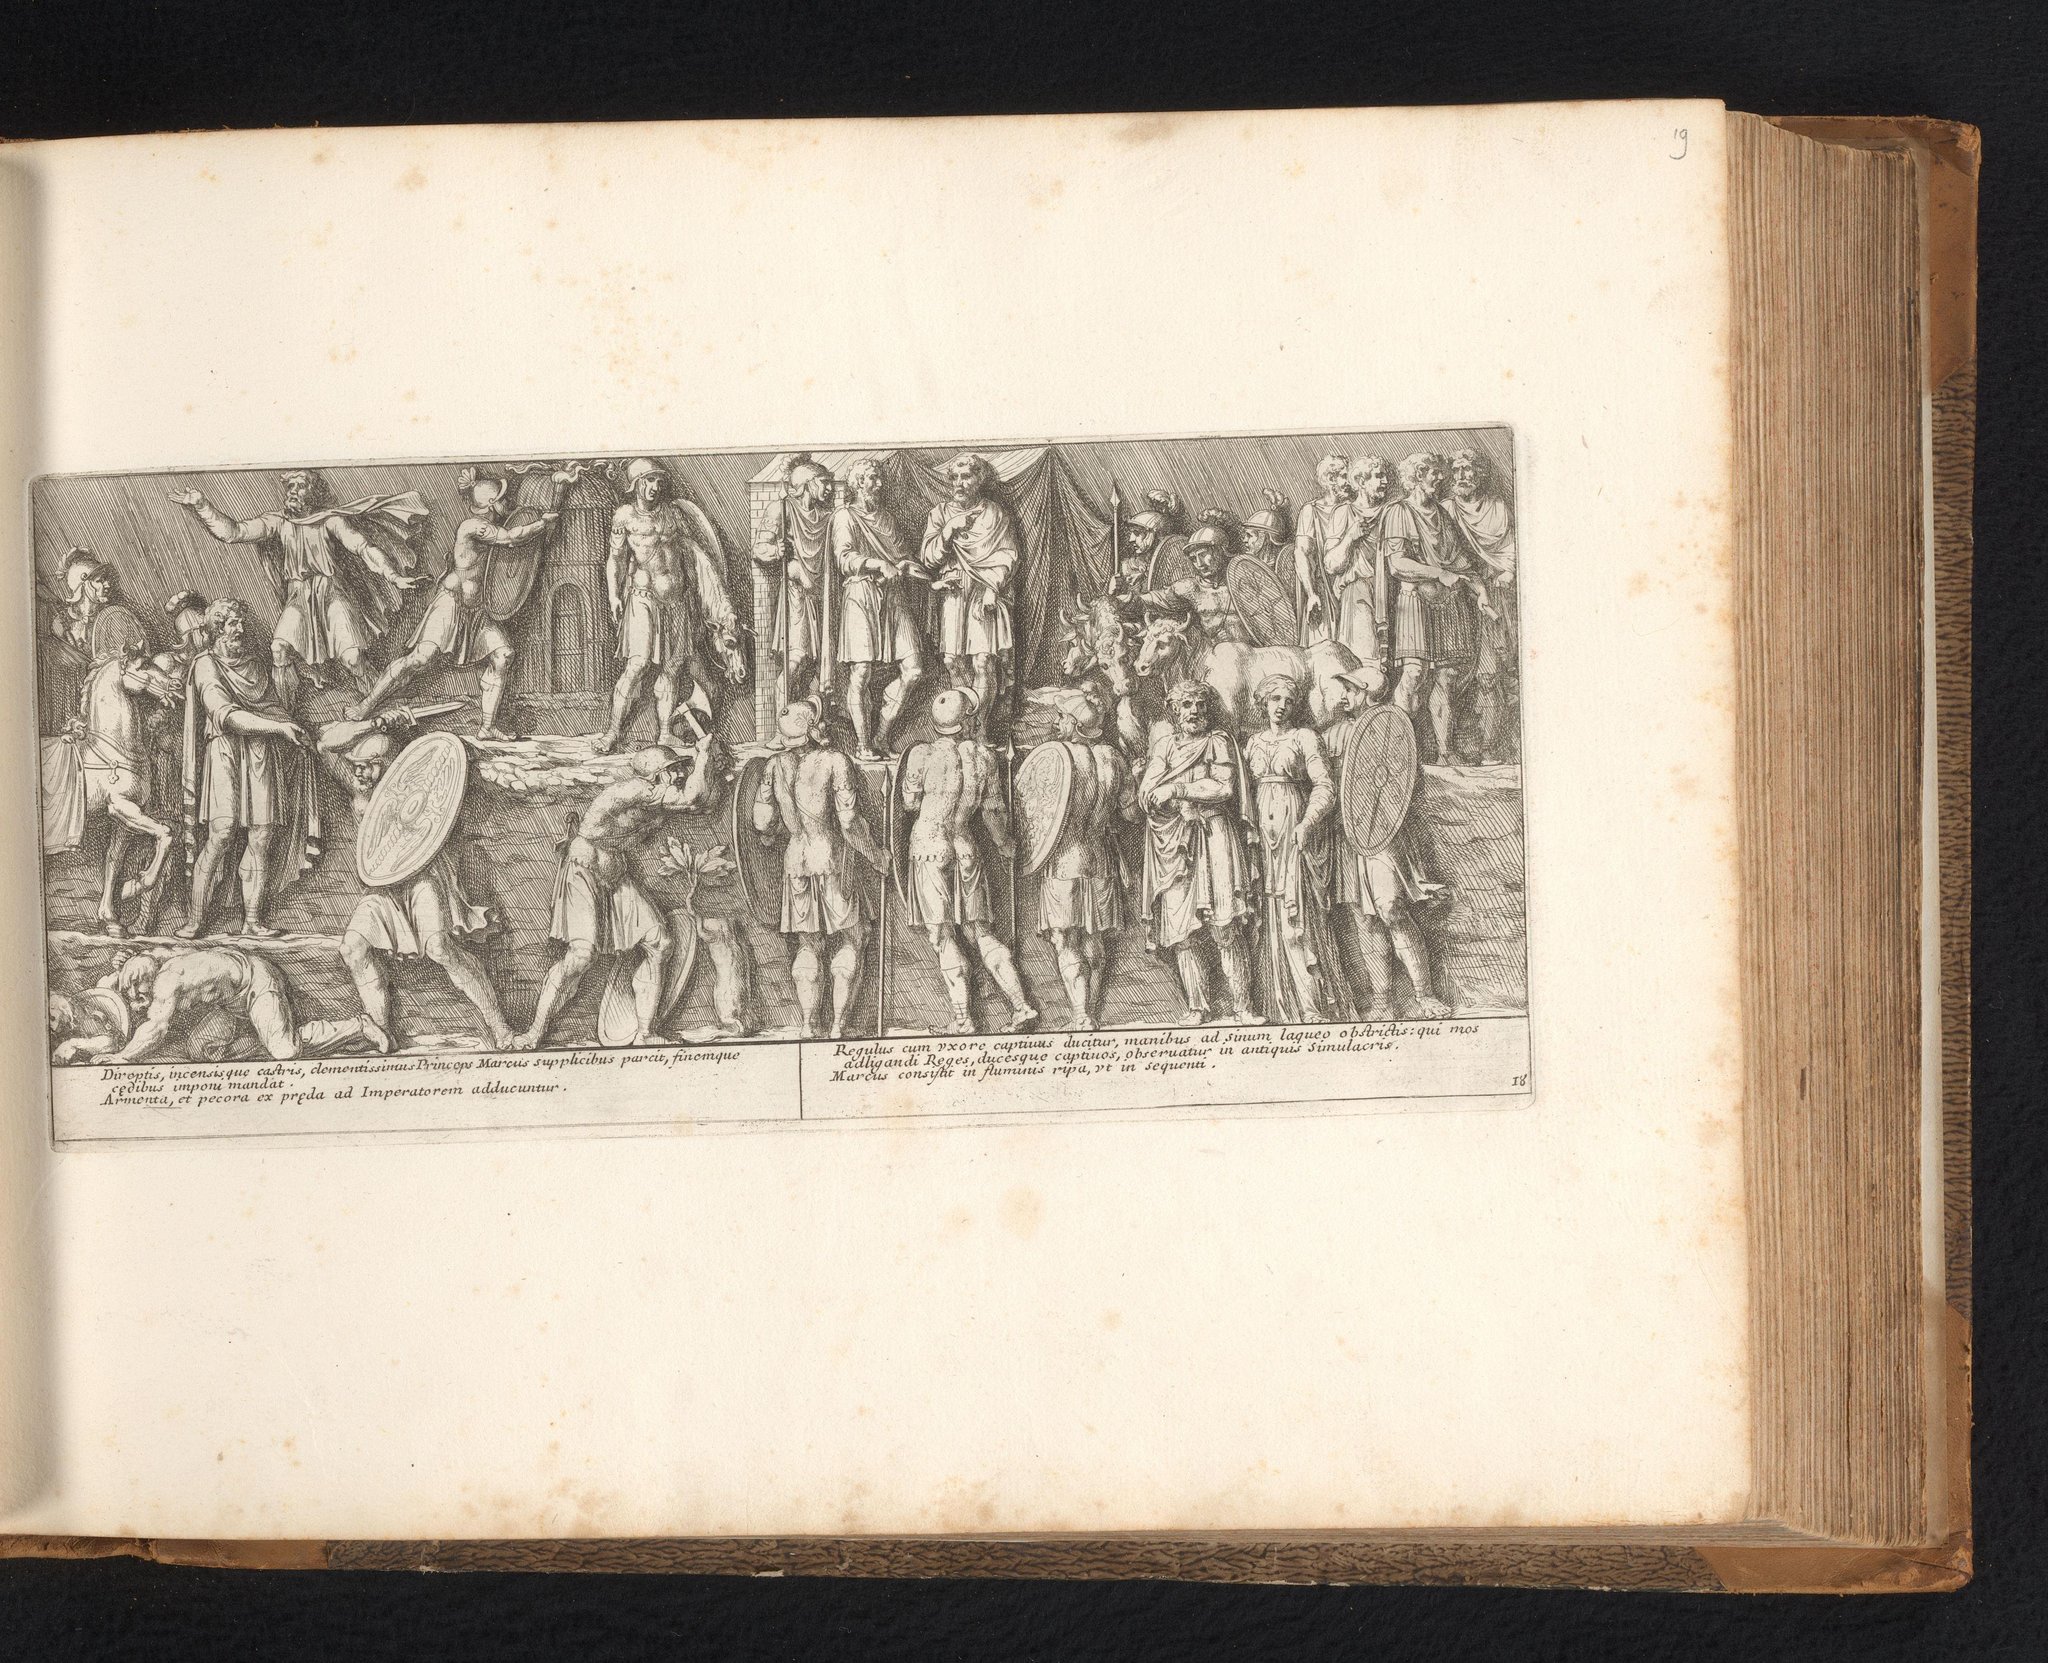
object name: print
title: Detail van het fries op de Zuil van Marcus Aurelius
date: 1672-1675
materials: paper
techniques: etching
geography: rome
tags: triumphal column with helical friezes, piece of sculpture, reproduction of a piece of sculpture, the soldier; the soldier's life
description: Detail van het spiraalvormige gebeeldhouwde fries op de Zuil van Marcus Aurelius te Rome. Het fries toont de oorlog tussen het Romeinse leger van keizer Marcus Aurelius en de Germaanse stammen der Marcomannen en Quaden en de oorlog tegen de Sarmaten die vanuit het huidige Iran Hongarije waren binnengevallen. Tekst in de ondermarge. Prent maakt deel uit van een album.